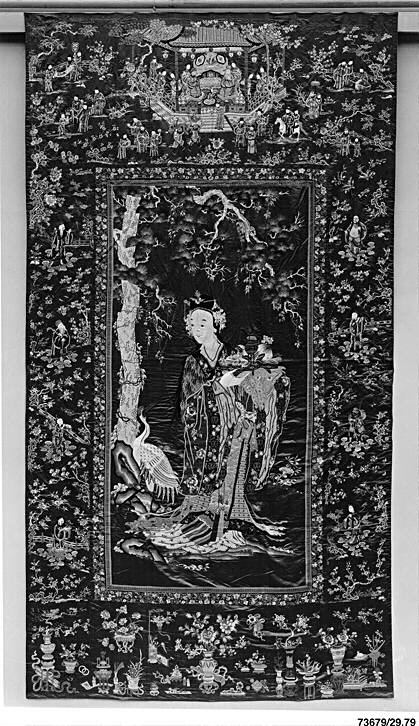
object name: hanging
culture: chinese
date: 1801-1900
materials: metal thread, silk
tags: birds,women